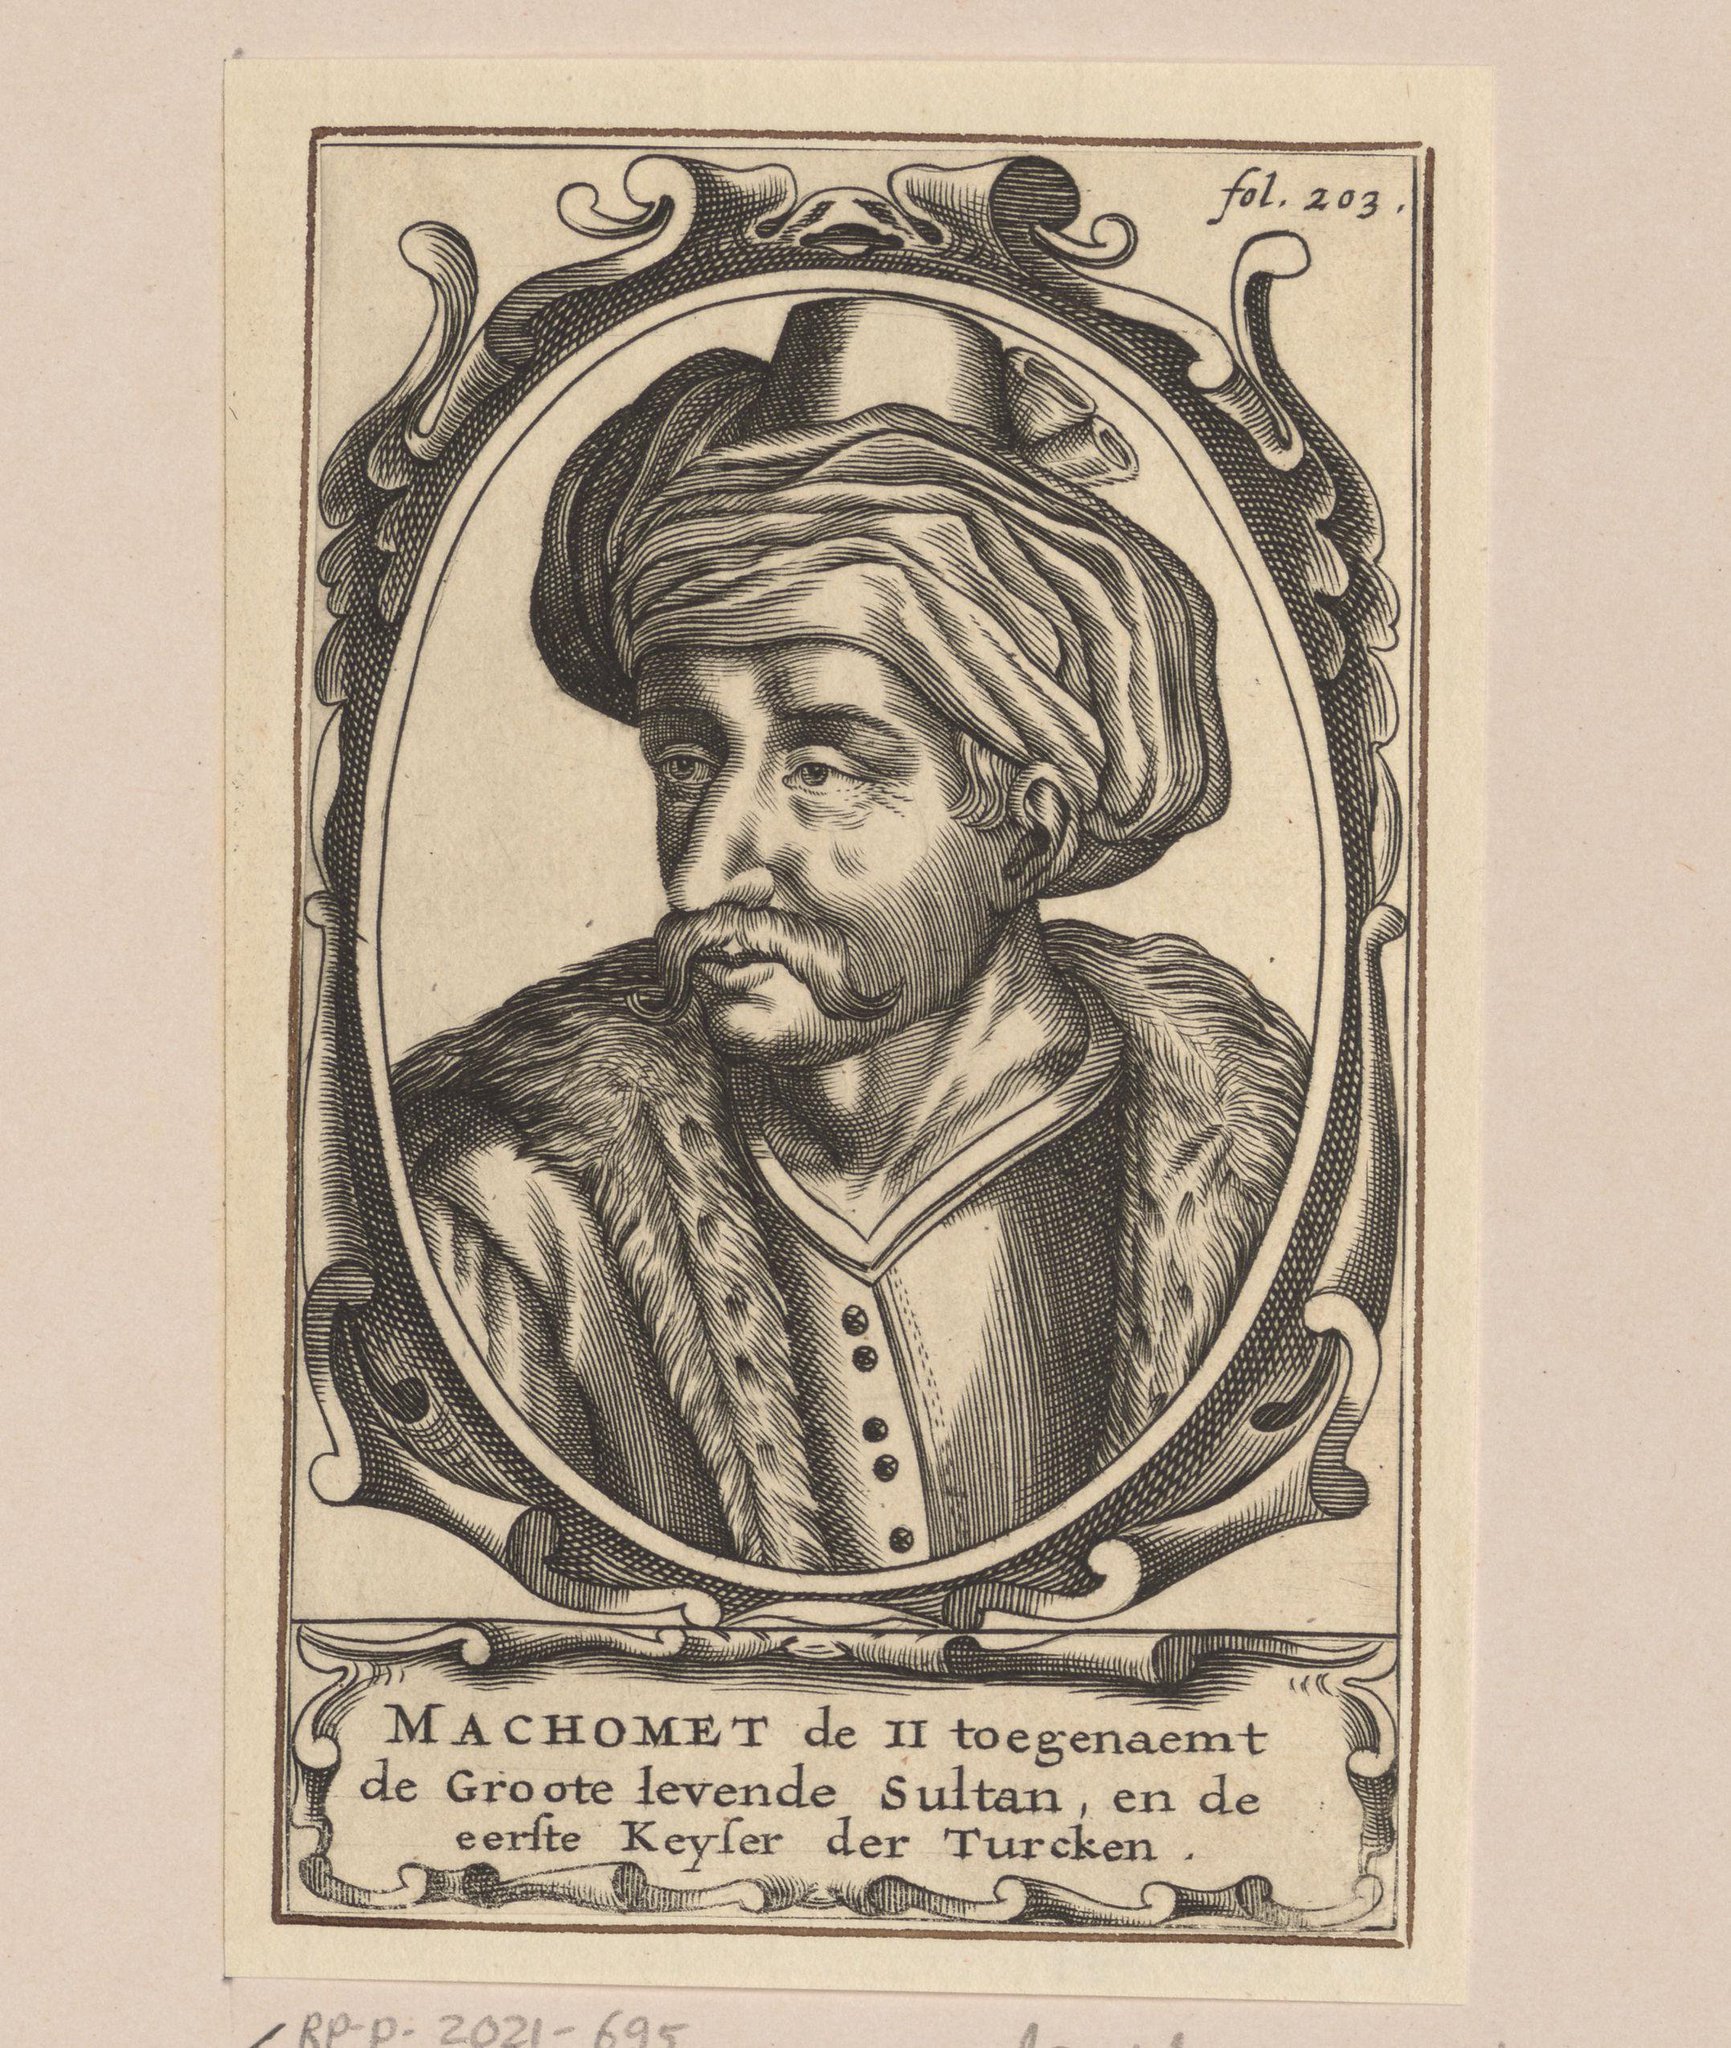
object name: book illustration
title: Portret van Mehmet II, sultan van het Ottomaanse Rijk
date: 1662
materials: paper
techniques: engraving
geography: amsterdam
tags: historical persons, head-gear: turban, ruler, sovereign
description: Prent uit: Corput, Abraham van den. De goddelicke vierschare, dat is, Ontdeckinge der hemelsche oordelen. Amsterdam: Johan van Waesberge, 1662, dl. 2, p. 203.